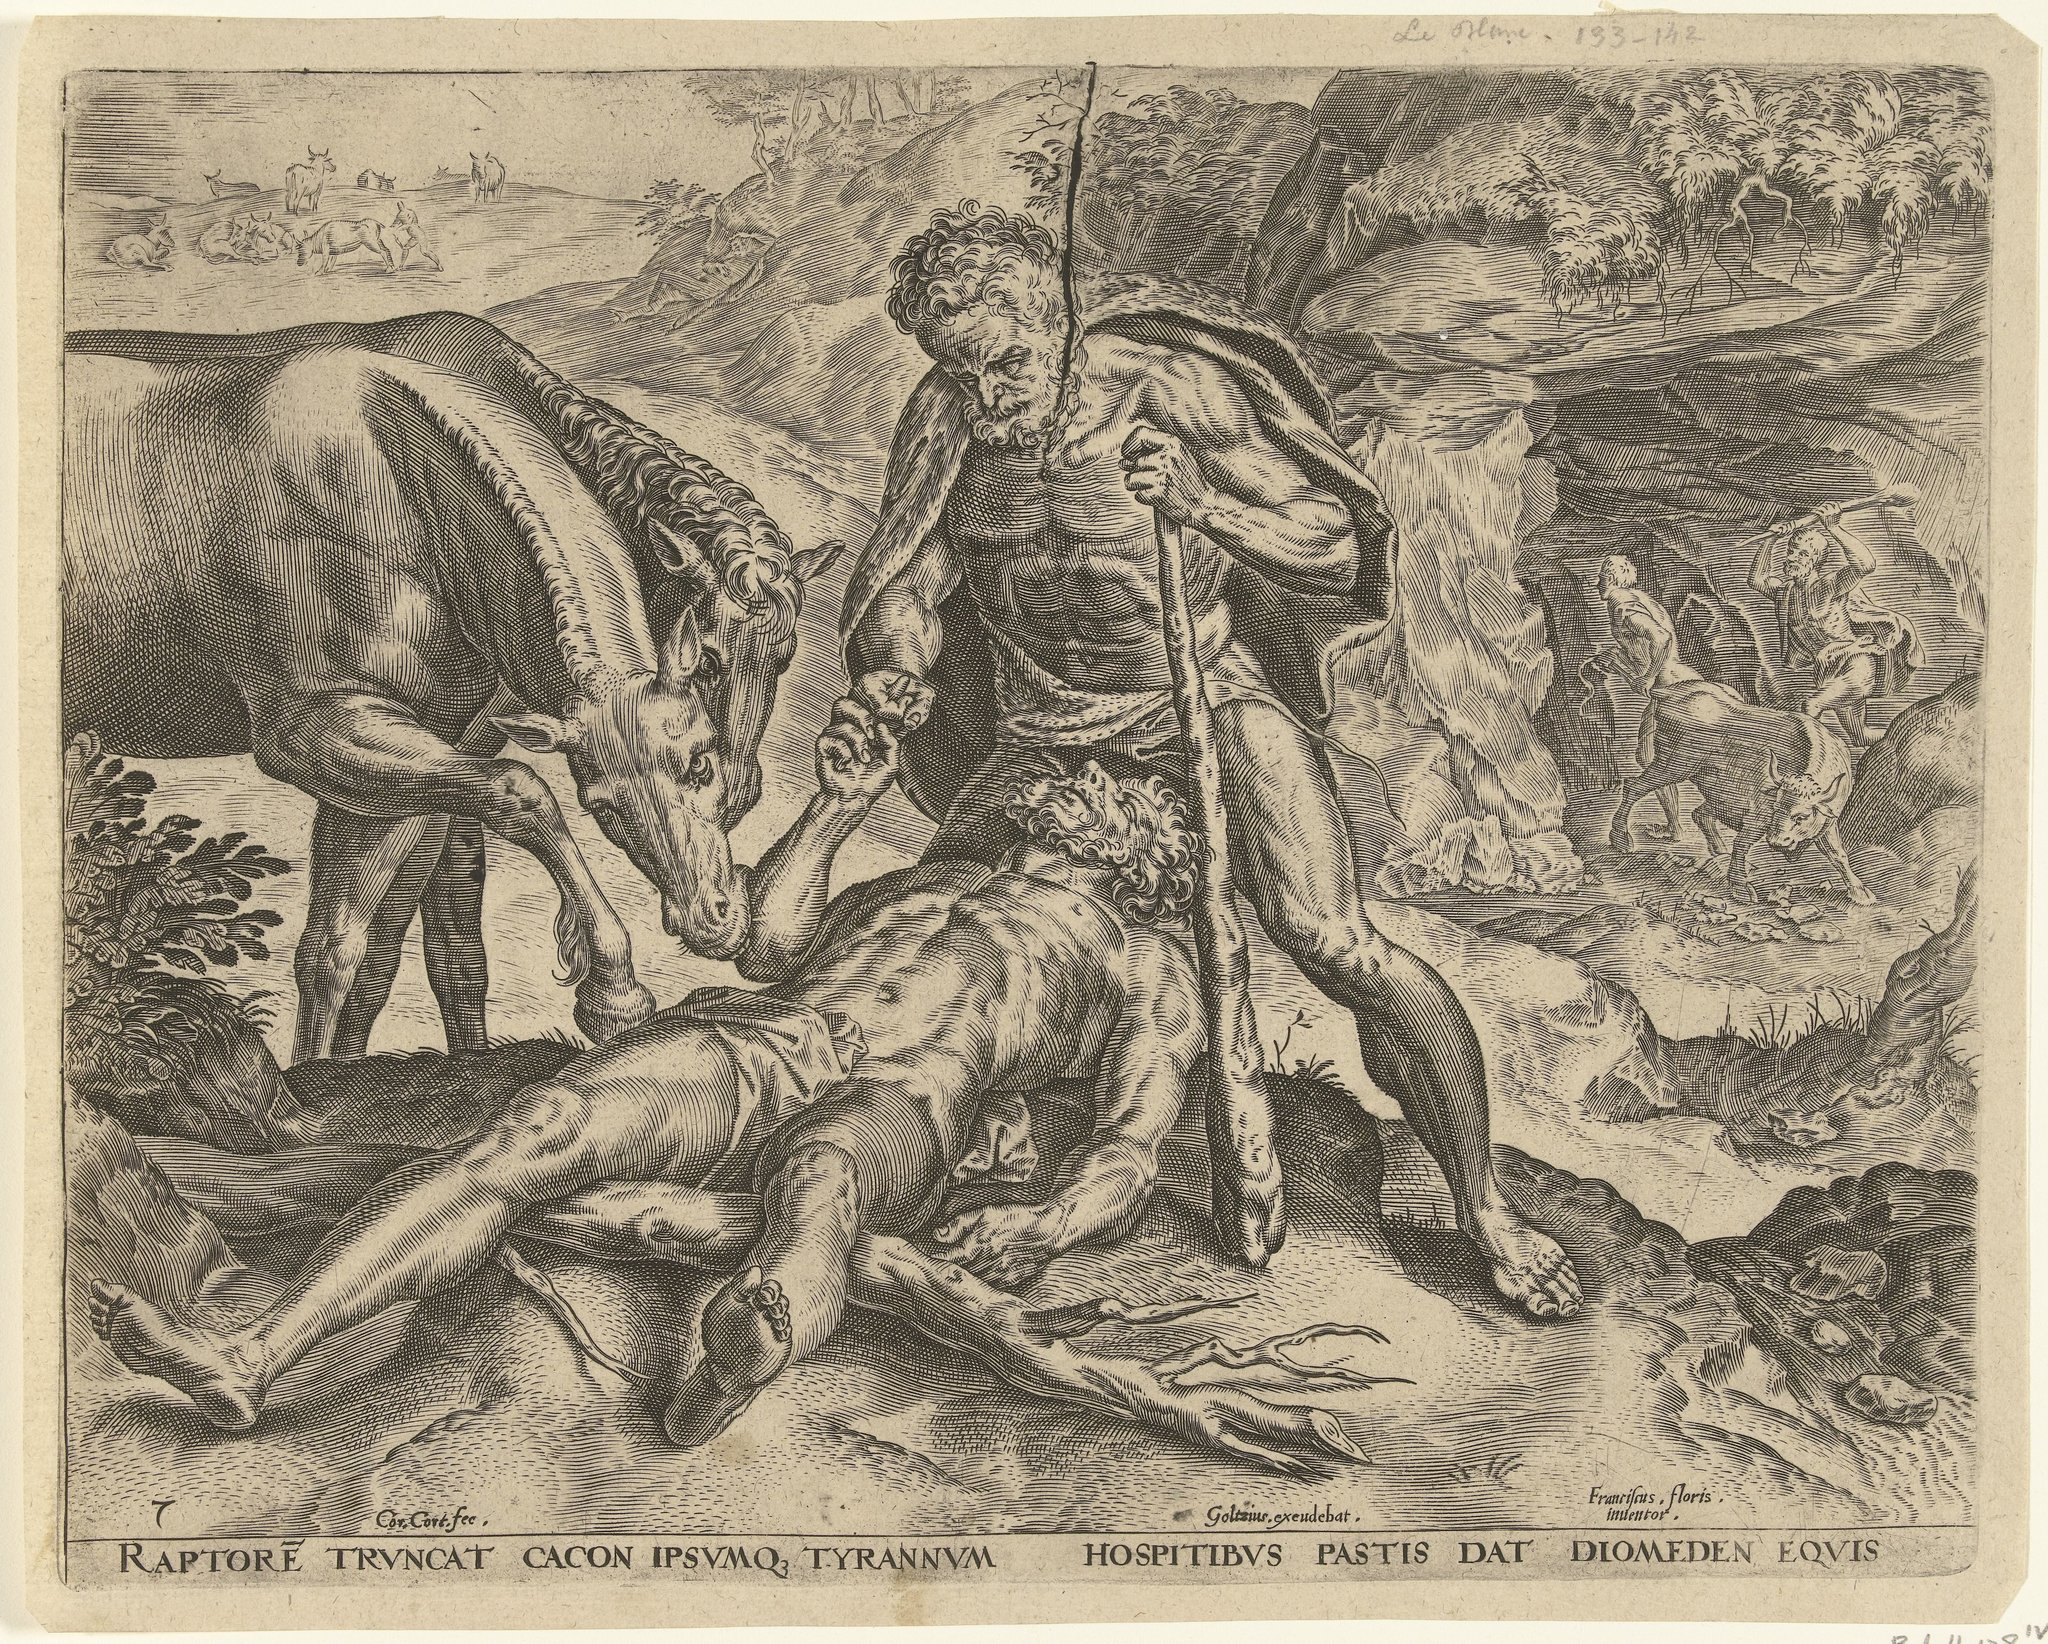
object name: print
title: Hercules voert Diomedes aan zijn paarden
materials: paper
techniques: engraving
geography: antwerp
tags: cacus steals some of the cattle of geryon which hercules was driving home, (8) the four mares of king diomedes are captured; when diomedes is slain in the ensuing battle his body is thrown to the mares to eat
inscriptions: collector's mark: Lugt 2228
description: De paarden van Diomedes werden met mensenvlees gevoerd. In een gevecht slaat Hercules Diomedes dood en voert vervolgens zijn lichaam aan diens paarden. Op de achtergrond is Hercules te zien die de reus Cacus doodslaat. Cacus heeft een rund uit Hercules kudde gestolen en sleept het aan zijn staat naar zijn grot. Hercules verrast hem met zijn knots.